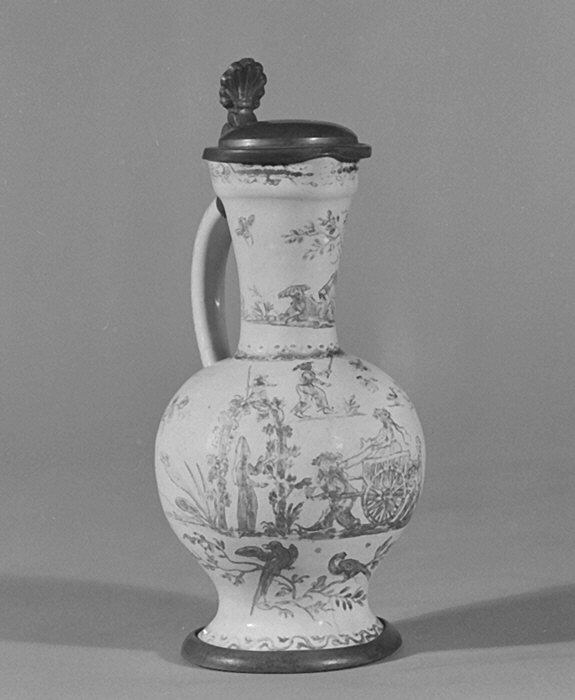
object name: jug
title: Small jug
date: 1667-1700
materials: earthenware, pewter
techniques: glazing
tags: human figures,birds,plants,carriages